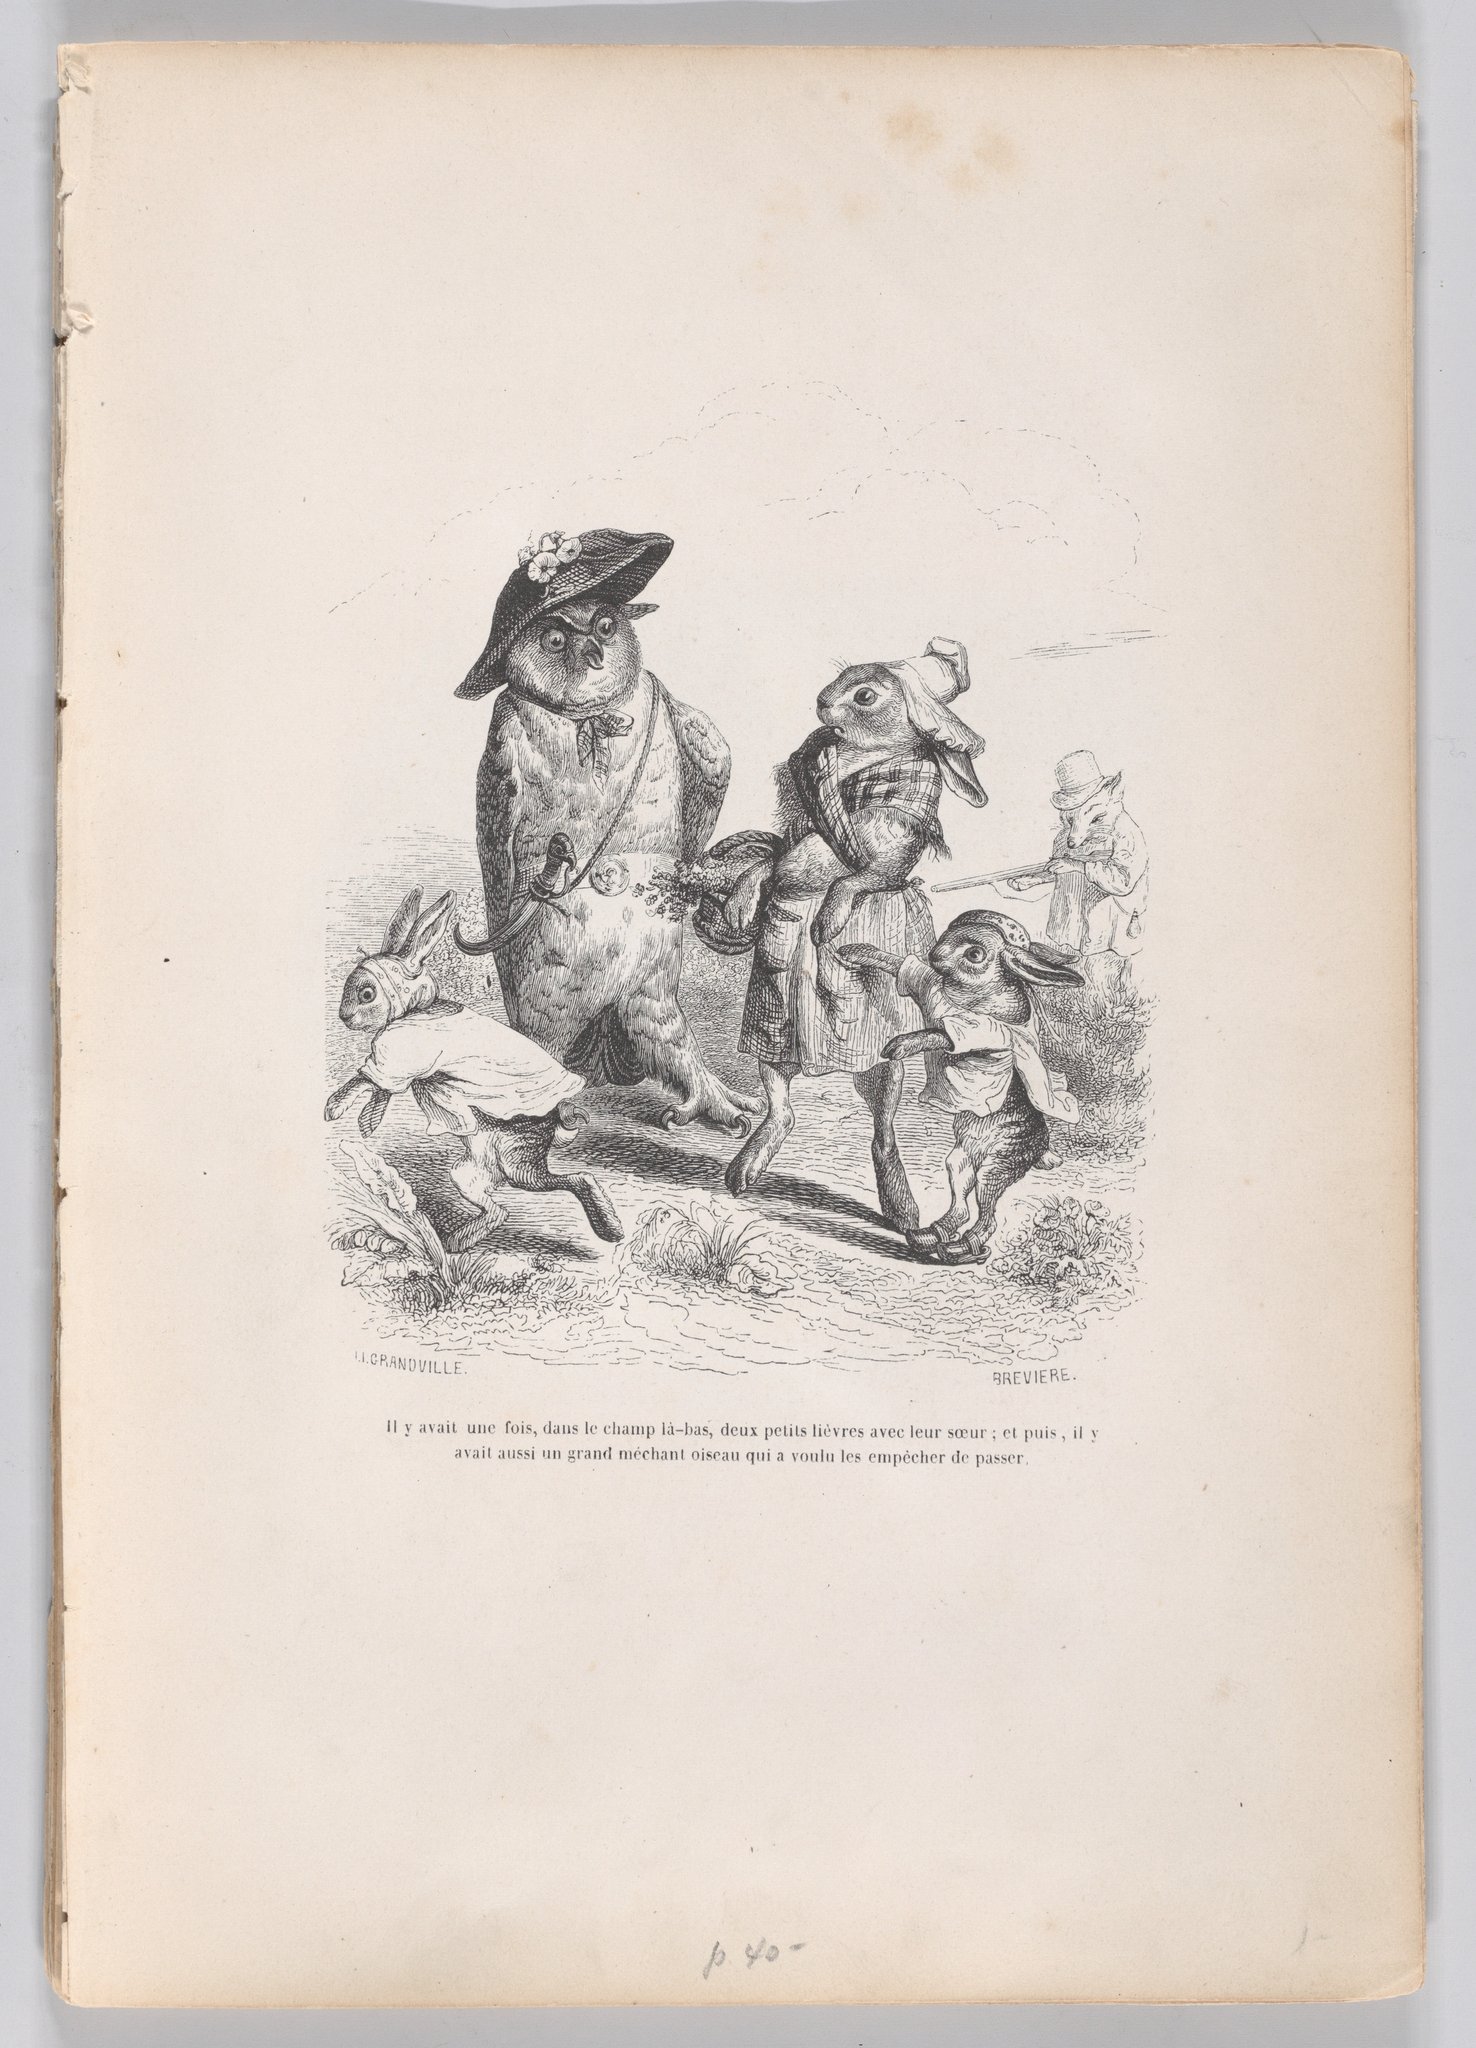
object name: print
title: There was once, in the camp there, two little hares with their sister, and then there was also a big bad bird who wanted to stop them from passing, from "Scenes from the Private and Public Life of Animals"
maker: j. j. grandville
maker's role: illustrator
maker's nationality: french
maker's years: 1803-1847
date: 1837-1847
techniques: engraving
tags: owls,rabbits